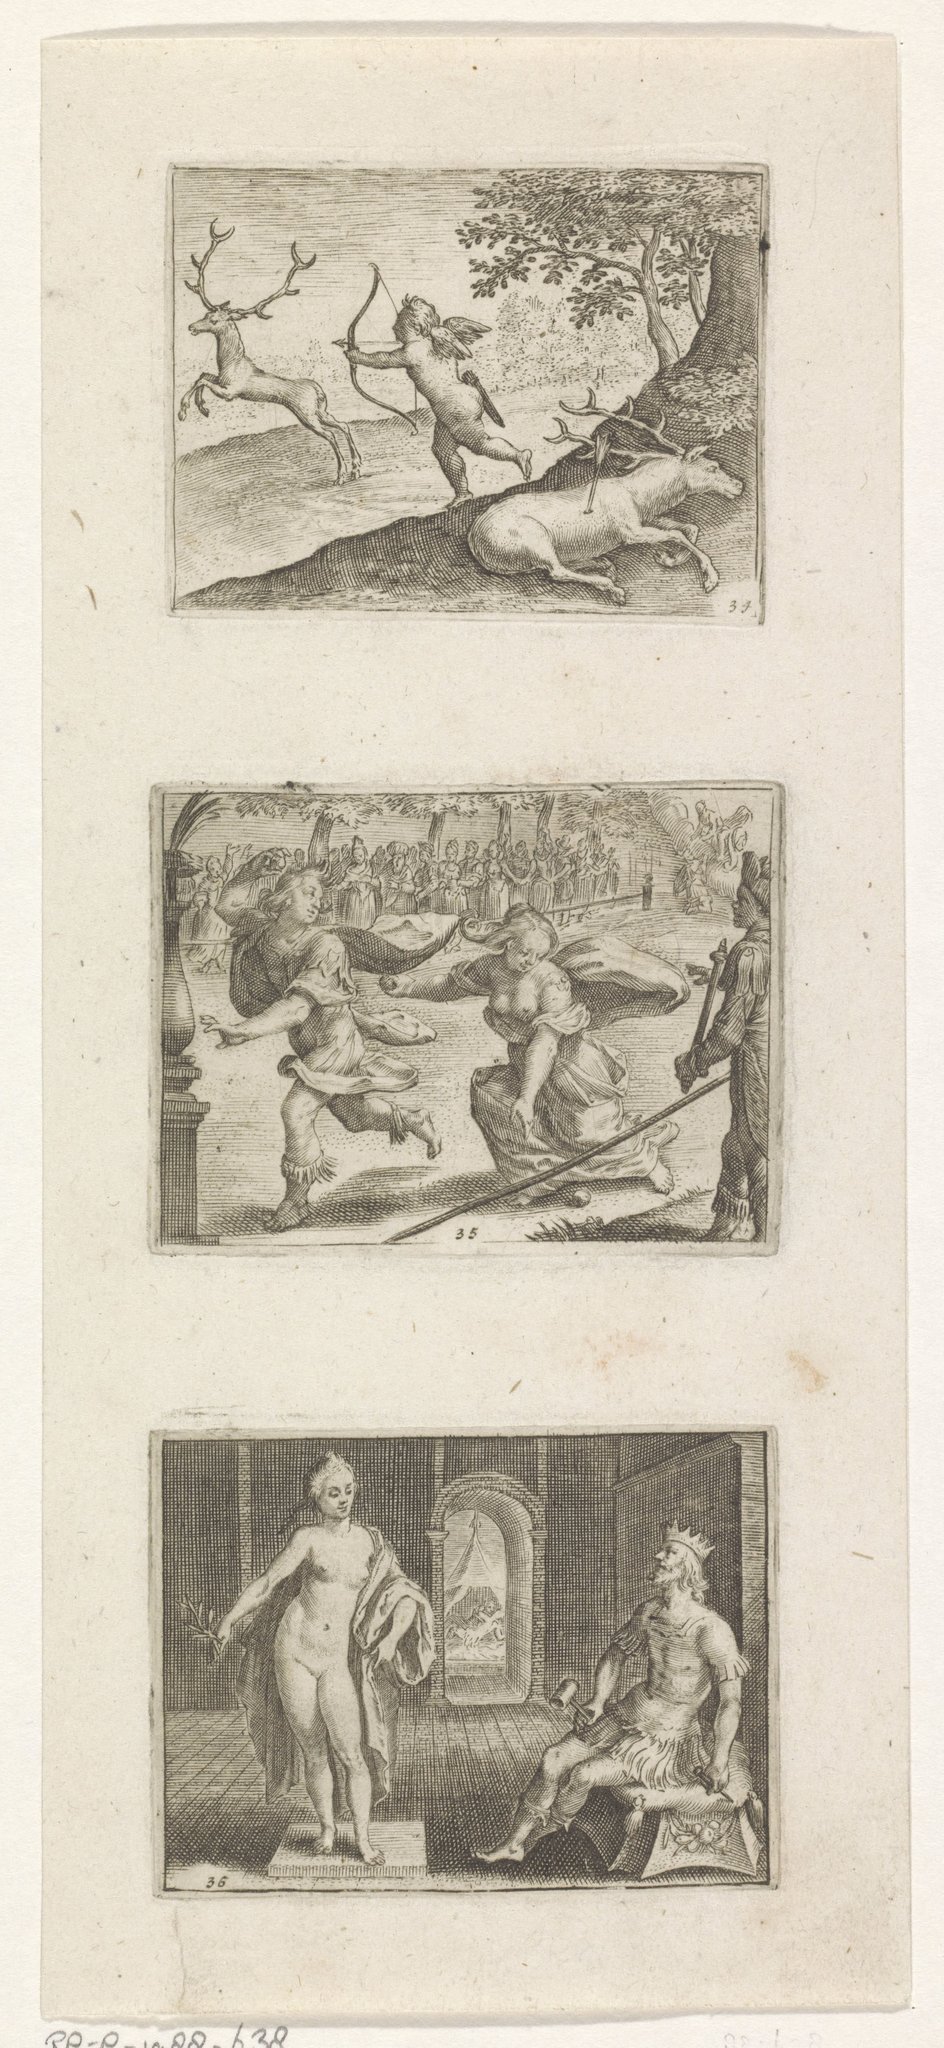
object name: print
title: Amor schiet een hert / Atalanta en Hippomenes / Pygmalion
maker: monogrammist mp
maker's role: print maker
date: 1680-1800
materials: paper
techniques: engraving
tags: cupid handling his weapons, stag-hunting, during the foot-race hippomenes drops the three golden apples; atalante stops to pick them up, and is thus beaten, statue coming to life: at pygmalion's prayer, a statue (latterly called galatea) comes to life; a favour of venus (ovid, metamorphoses x 280)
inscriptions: collector's mark: Lugt 2228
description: Drie voorstellingen van verhalen uit de Metamorfosen op een blad. Boven: Amor schiet op een hert. Wellicht Actaeon. Midden: Atalanta en Hippomenus doen een hardloopwedstrijd. Atalanta raapt de gouden appels op die Hippomenus laat vallen waardoor ze de wedstrijd verliest. Onder: Pygmalion, koning van Cyprus, wordt verliefd op het beeld van Venus dat hij vervaardigd heeft. Het beeld komt tot leven.